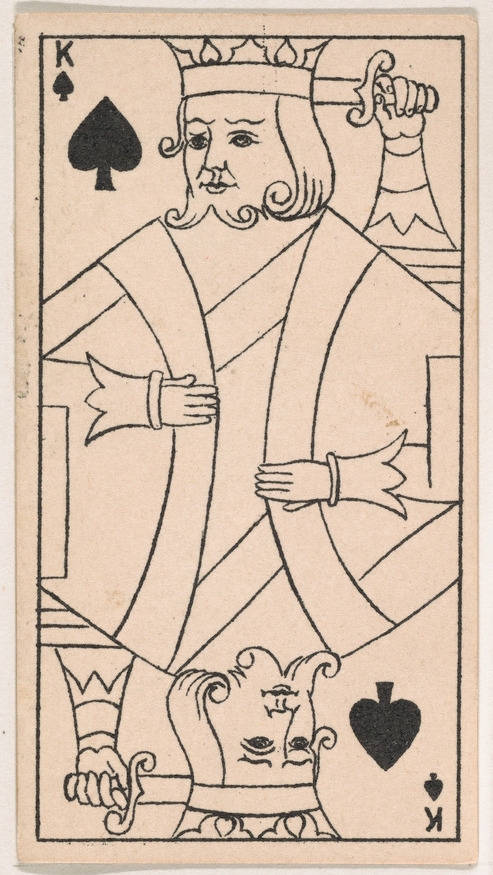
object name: print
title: King of Spades, from the Transparent Playing Cards series (N220) issued by Kinney Bros.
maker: kinney brothers tobacco company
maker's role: publisher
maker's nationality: american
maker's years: 1869-2011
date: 1888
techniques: color lithograph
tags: kings,playing cards